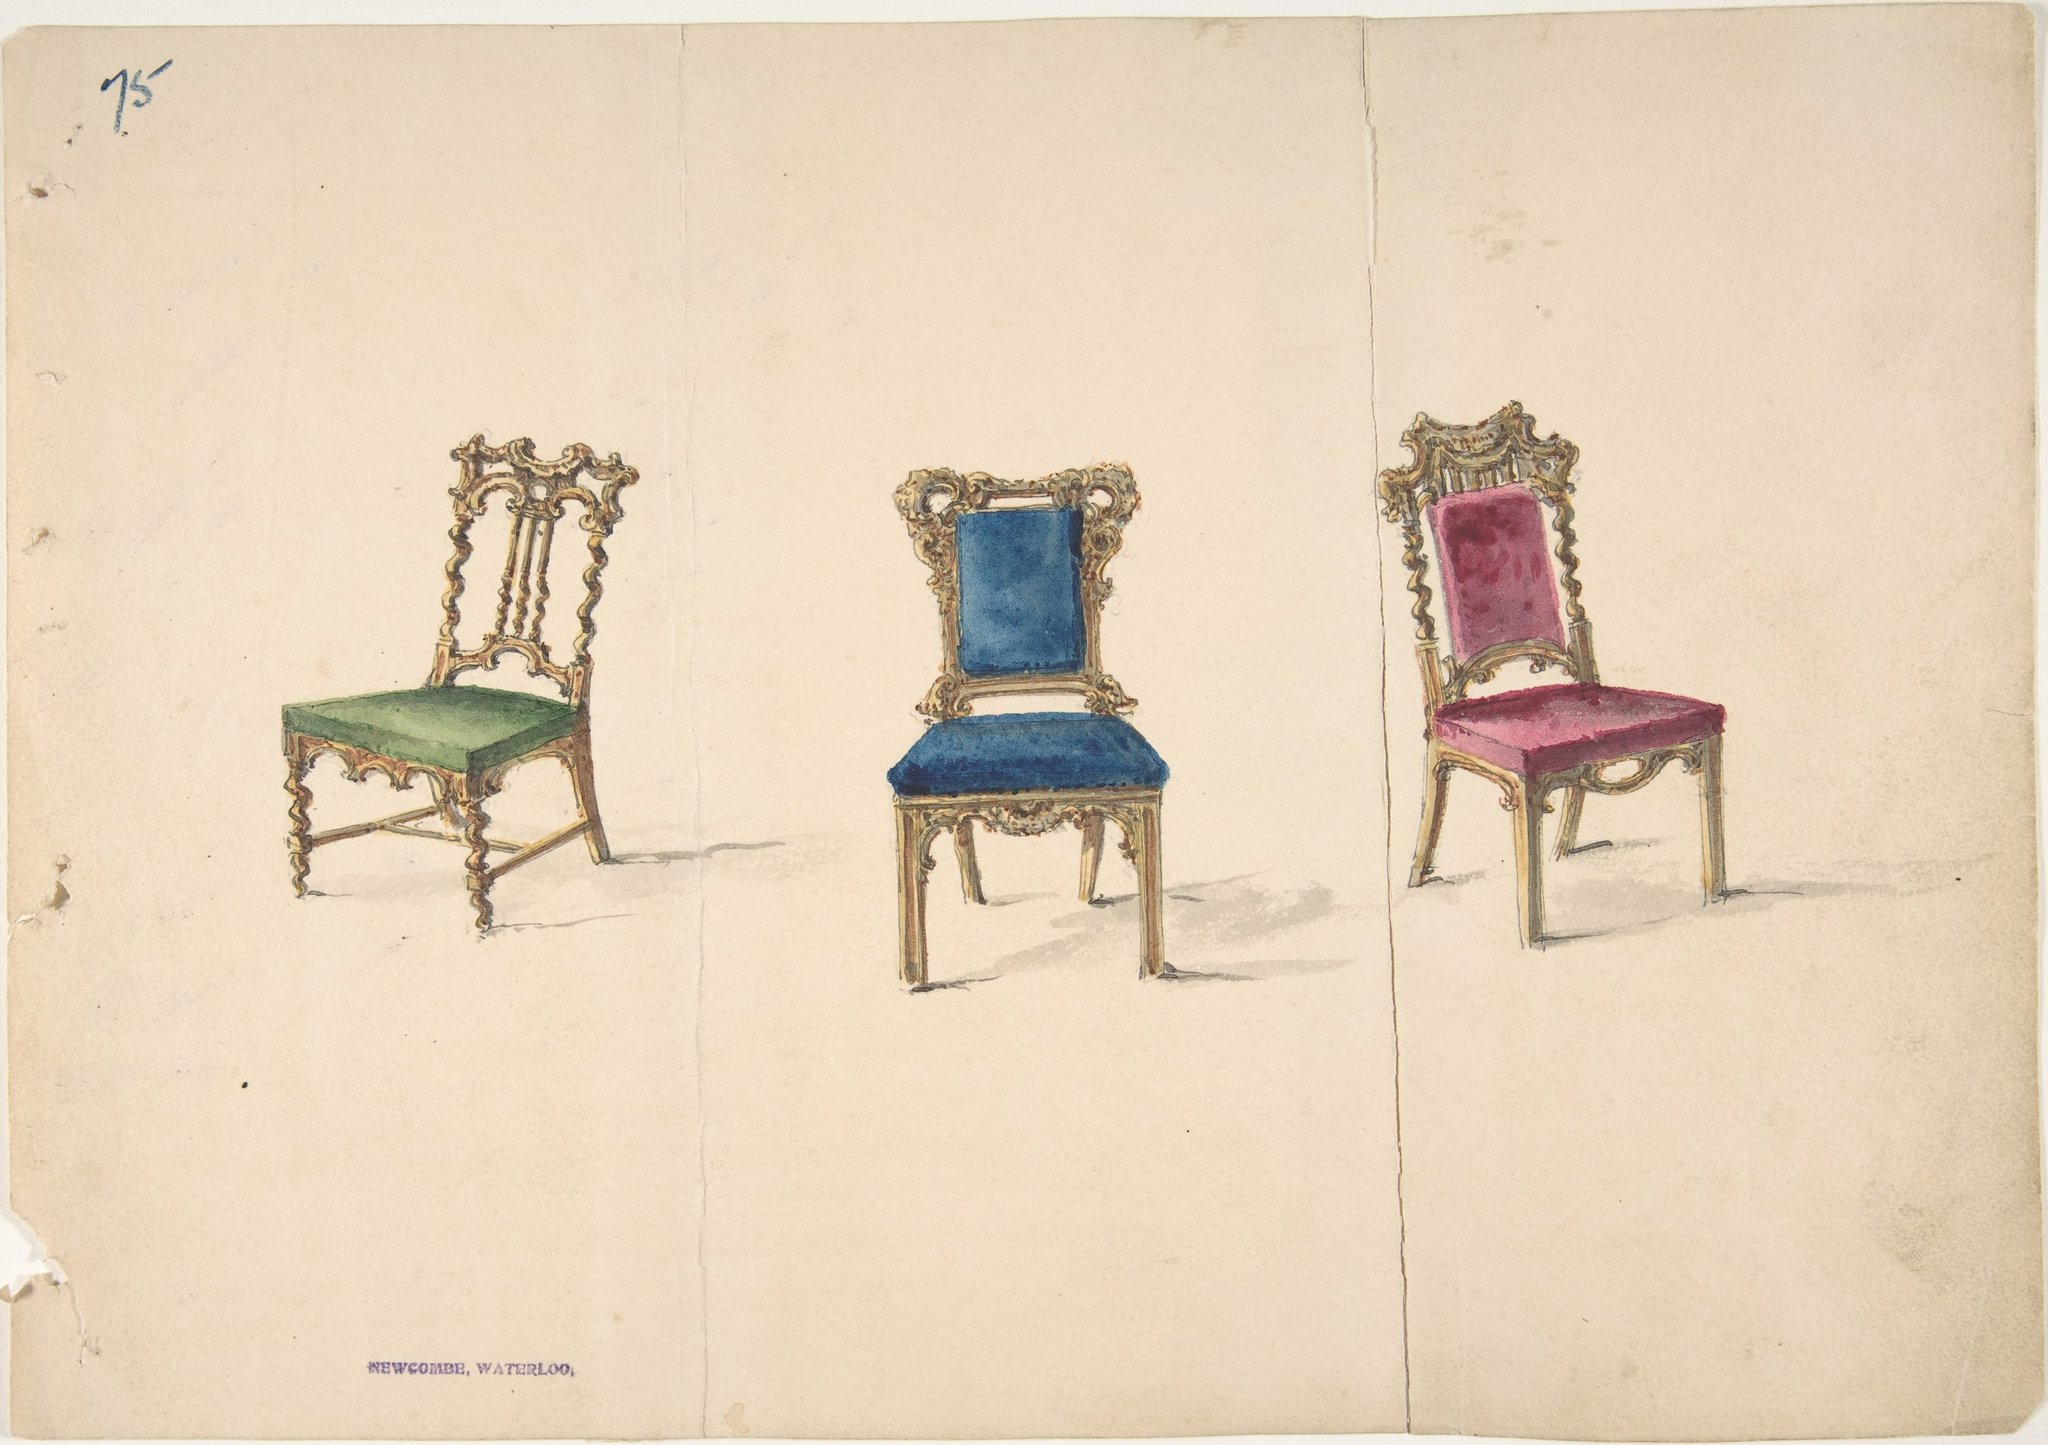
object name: drawing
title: Designs for Three Chairs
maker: anonymous, british, 19th century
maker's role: artist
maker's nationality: british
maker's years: 1800-1900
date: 1801-1833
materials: ink, watercolor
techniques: brush, pen, wash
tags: chairs